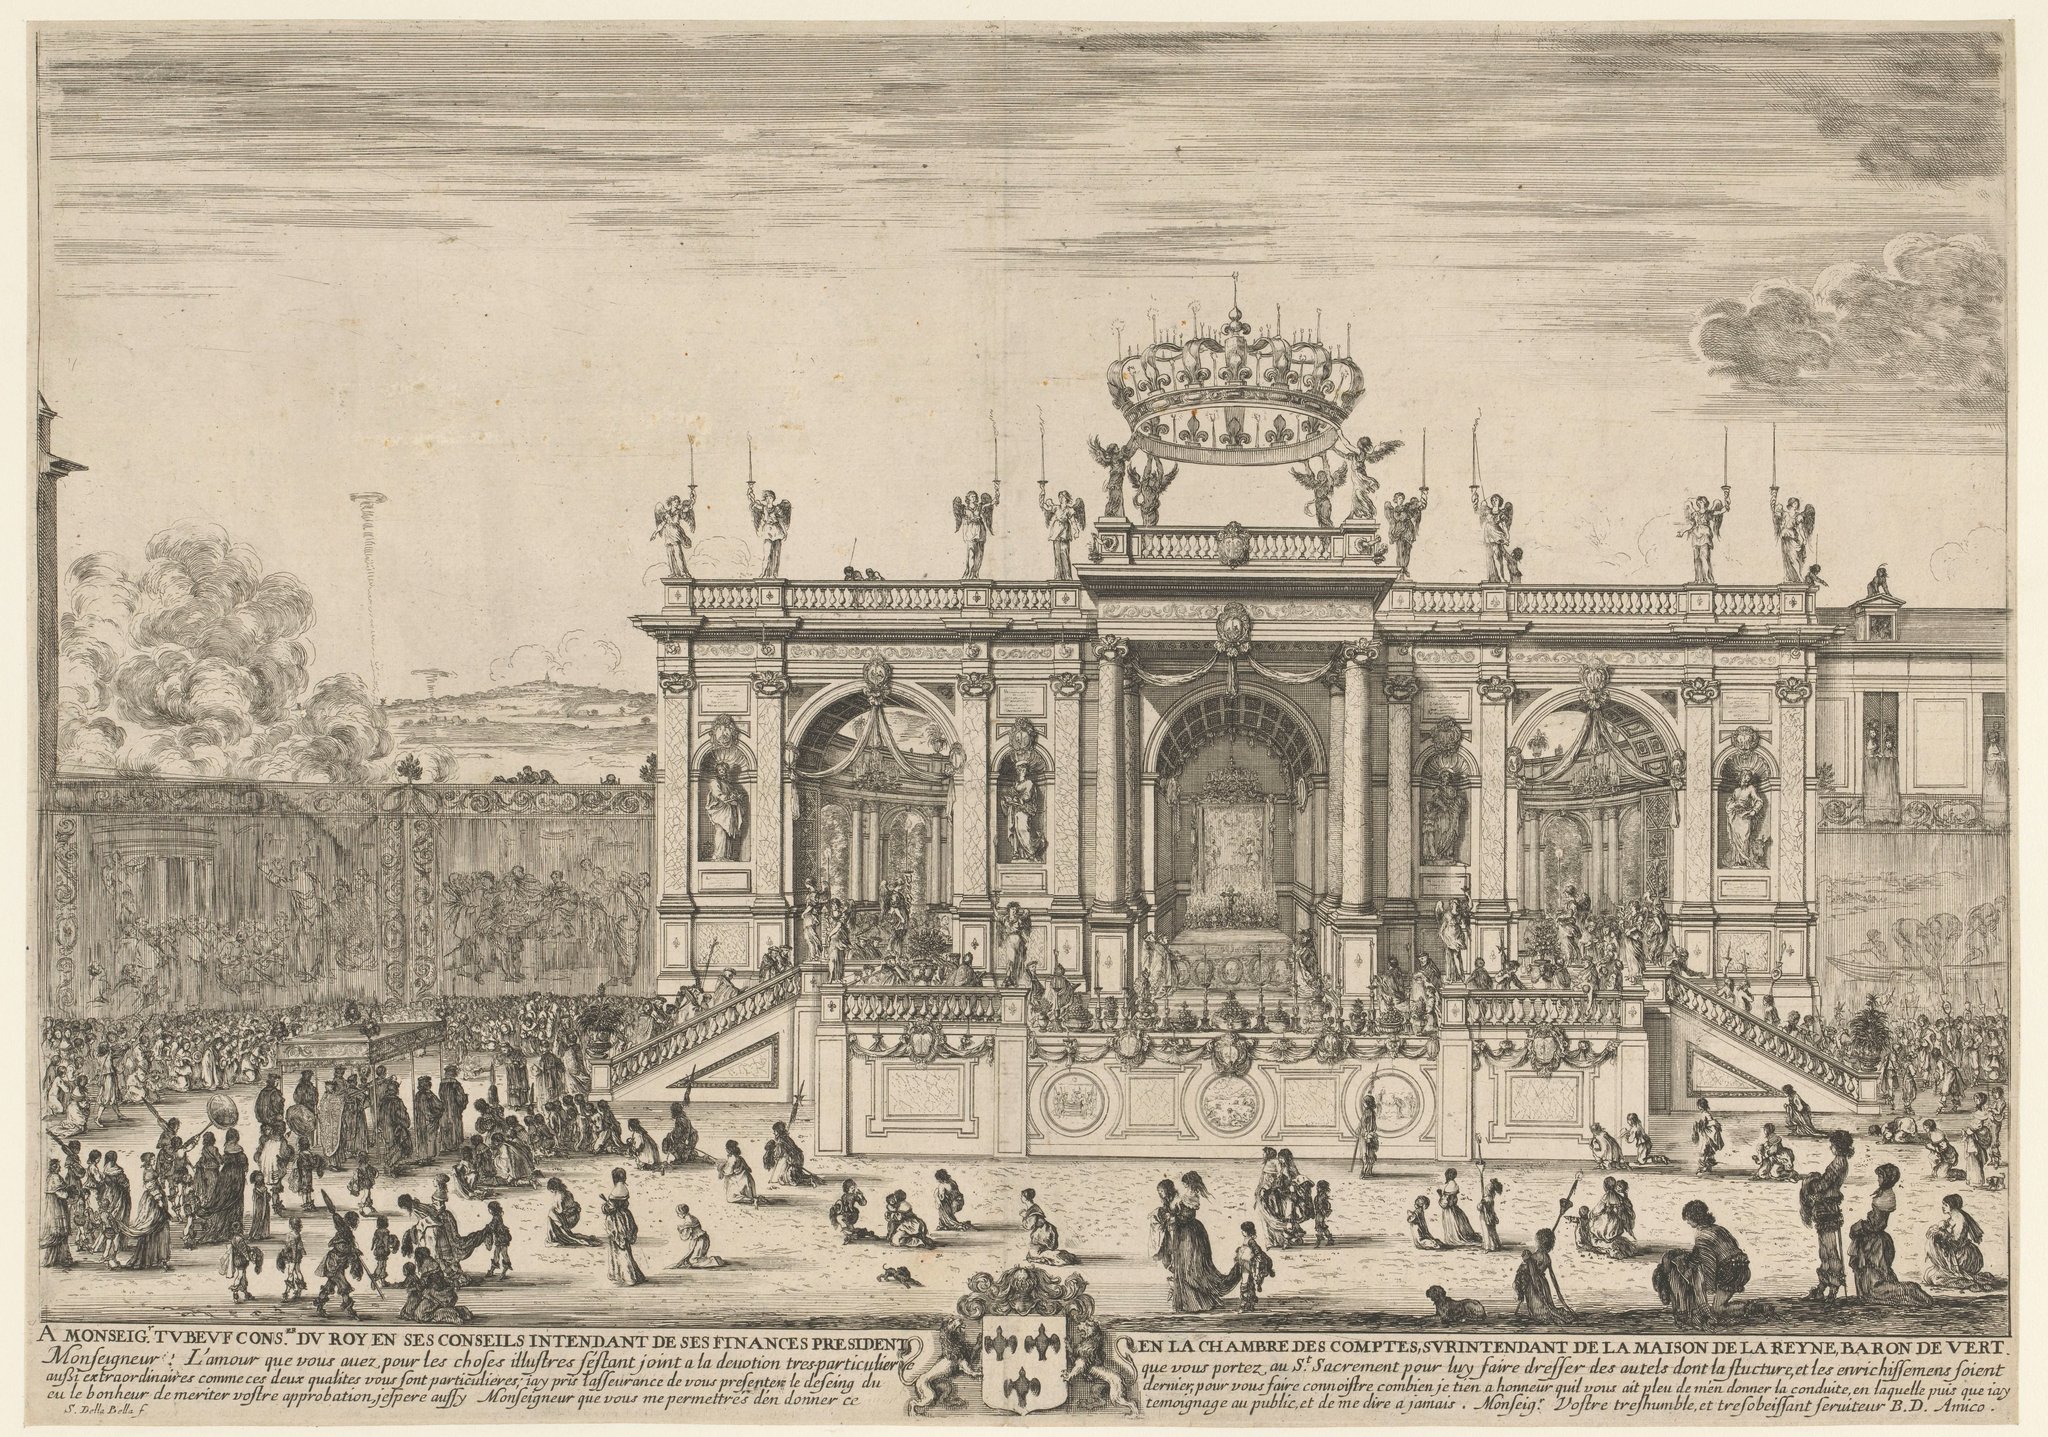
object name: ornament print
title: Altaar van het Heilige Sacrament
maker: stefano della bella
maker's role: draughtsman, print maker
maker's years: 1610-1664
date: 1648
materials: paper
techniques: etching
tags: paris, anna van oostenrijk (koningin van frankrijk), lodewijk xiv (koning van frankrijk), sacramentalia, procession ~ christian religion, altar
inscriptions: collector's mark: ‘D’, collector's mark: Lugt 2760, collector's mark: Lugt 2228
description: Links een processie waarin het Heilige Sacrament wordt gedragen onder een baldakijn, gevolgd door de jonge koning Lodewijk XIV en zijn moeder Anna van Oostenrijk. De processie leidt naar een groot bouwwerk met drie bogen, met een altaar onder de centrale boog en bovenop een grote kroon gedragen door engelen. Naast het bouwwerk een menigte toeschouwers geknield voor wandtapijten (naar de wandtapijten van Rafael in het Vaticaan). Tekst in het Frans en een wapenschild in de ondermarge.